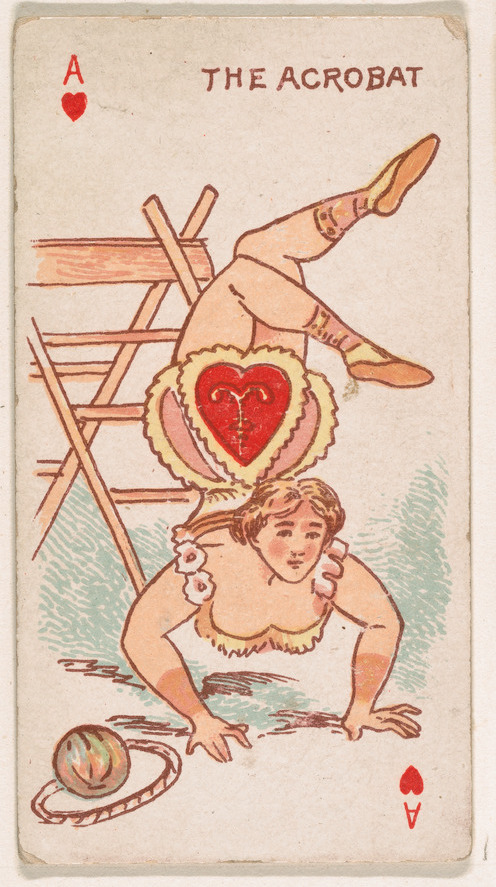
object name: print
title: Ace of Hearts, The Acrobat, The German, from Harlequin Cards, 2nd Series (N220) issued by Kinney Bros.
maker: kinney brothers tobacco company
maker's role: publisher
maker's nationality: american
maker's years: 1869-2011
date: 1889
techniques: color lithograph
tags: women,playing cards,acrobats